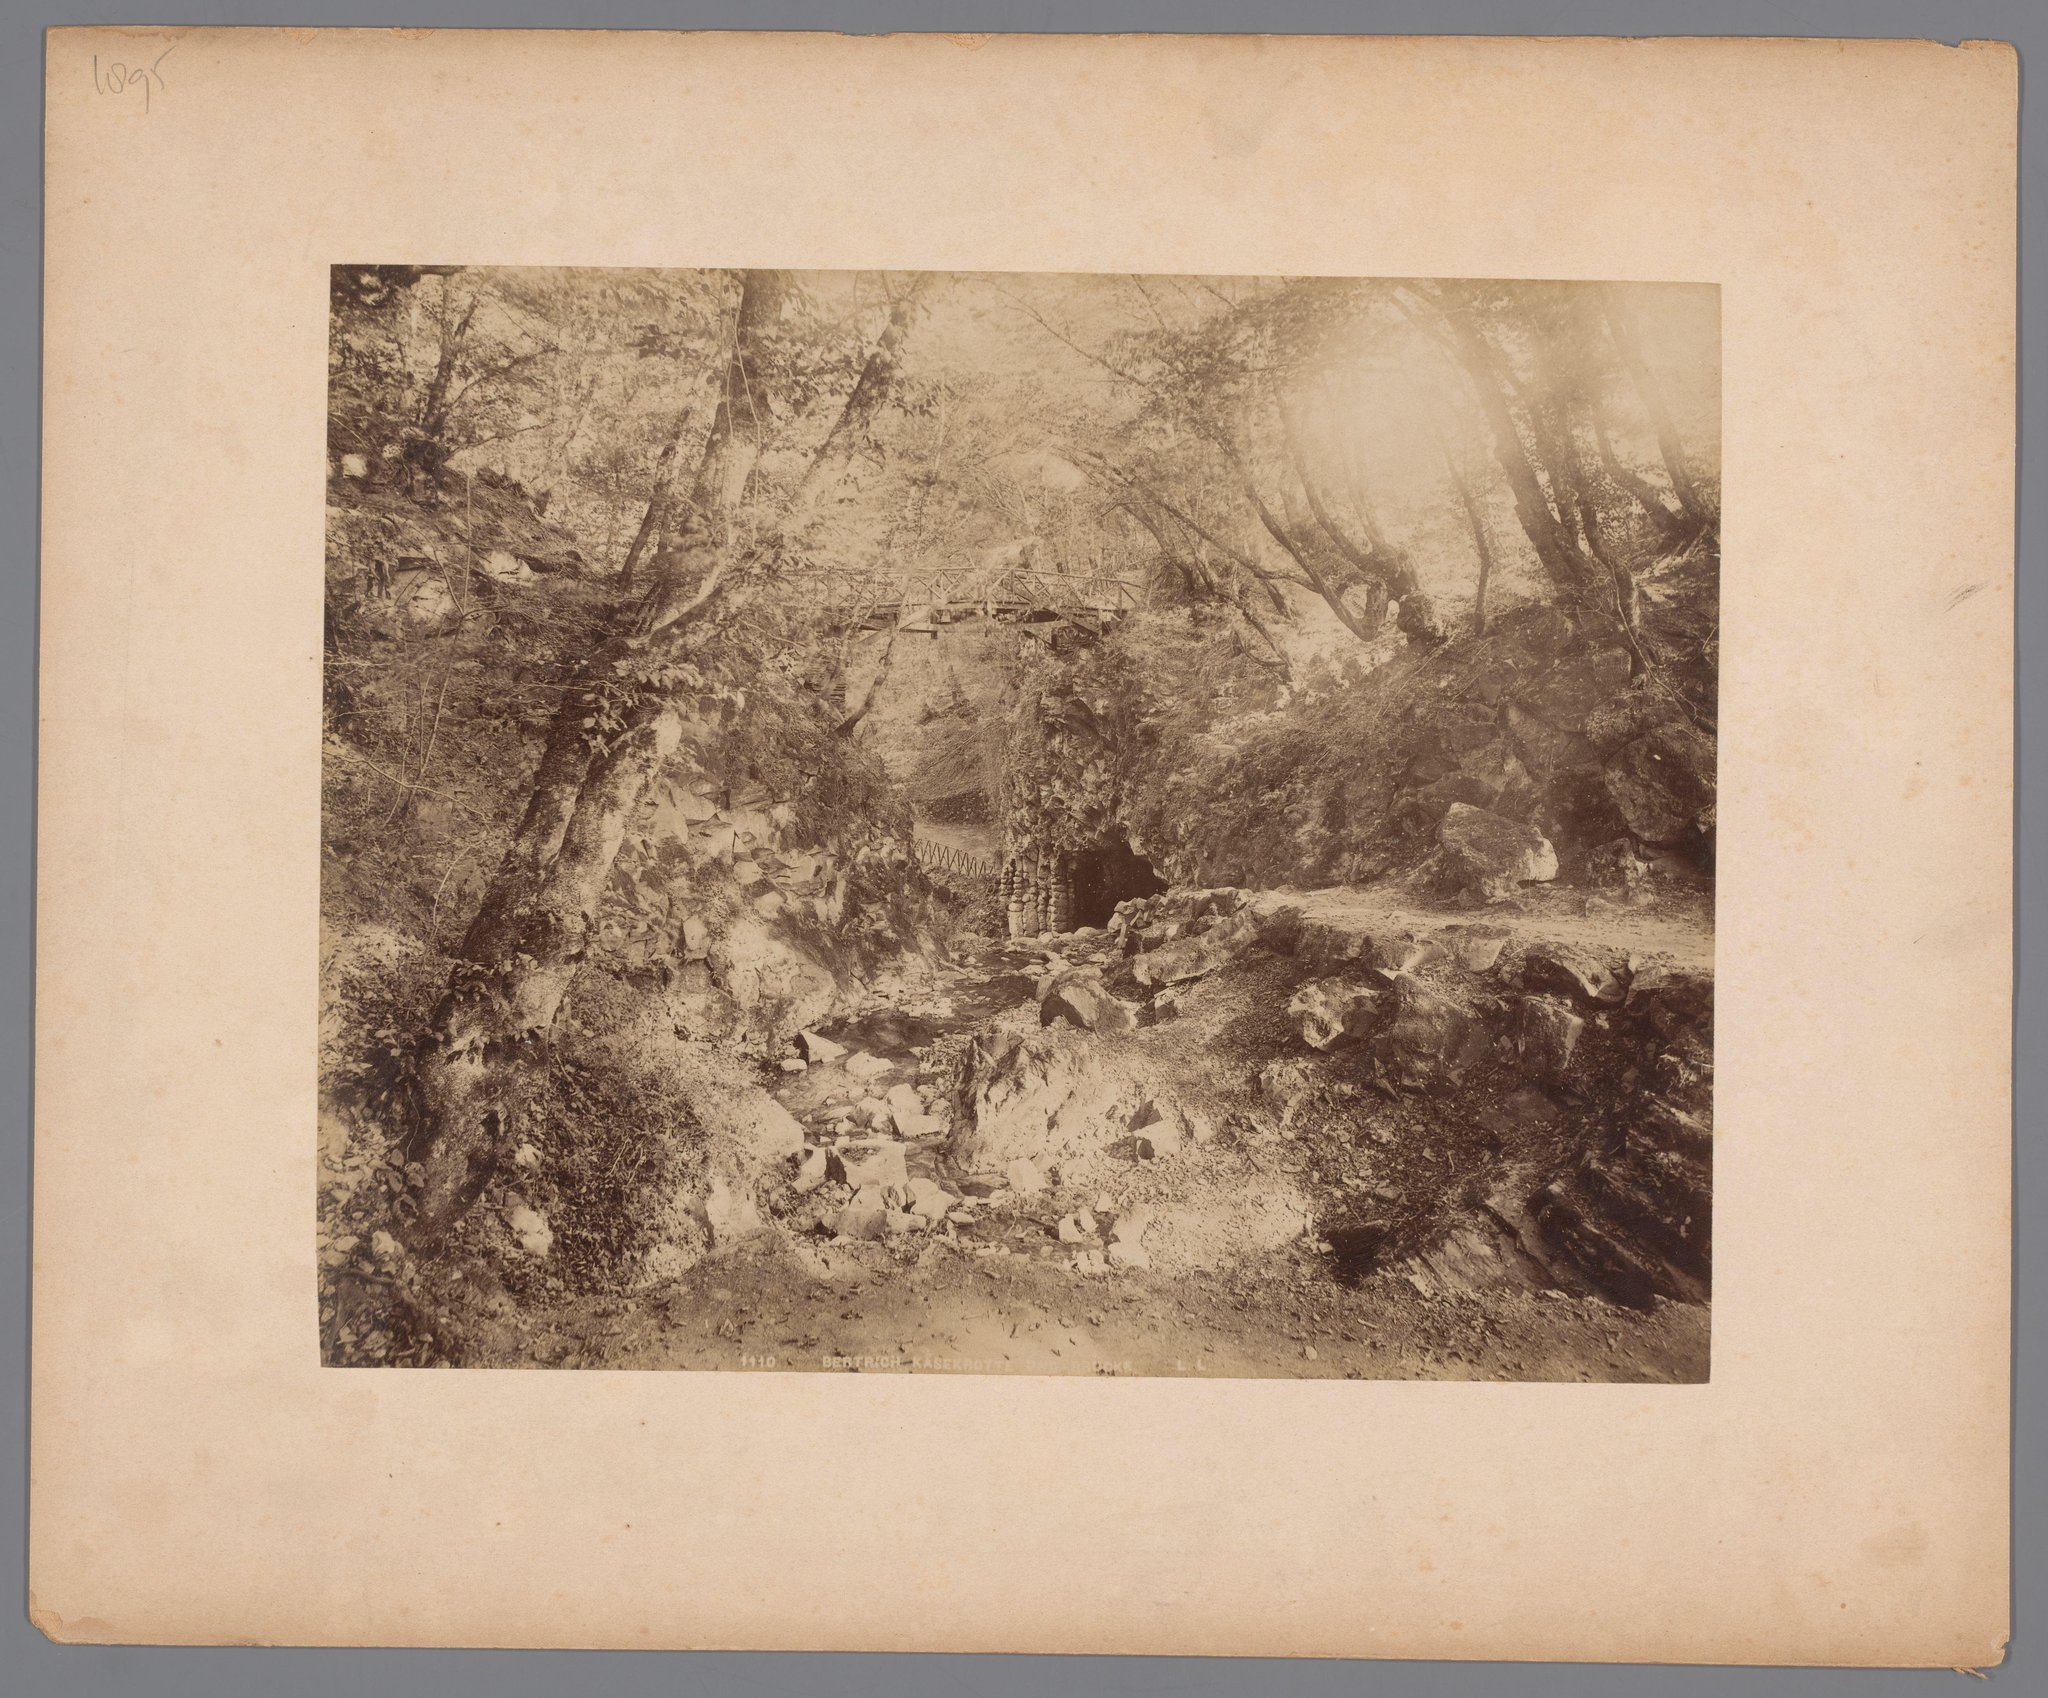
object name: photograph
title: "Käsegrotte", Bad Bertrich, Rijnland-Palts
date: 1890-1910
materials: cardboard, paper, photographic support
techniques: albumen print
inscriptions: inscription: ‘1110 Bertrich Käsekrotte [sic] und Brücke’, date: ‘1895’, initials: ‘L.L.’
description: "Käsegrotte", Bad Bertrich, Rijnland-Palts, Duitsland.